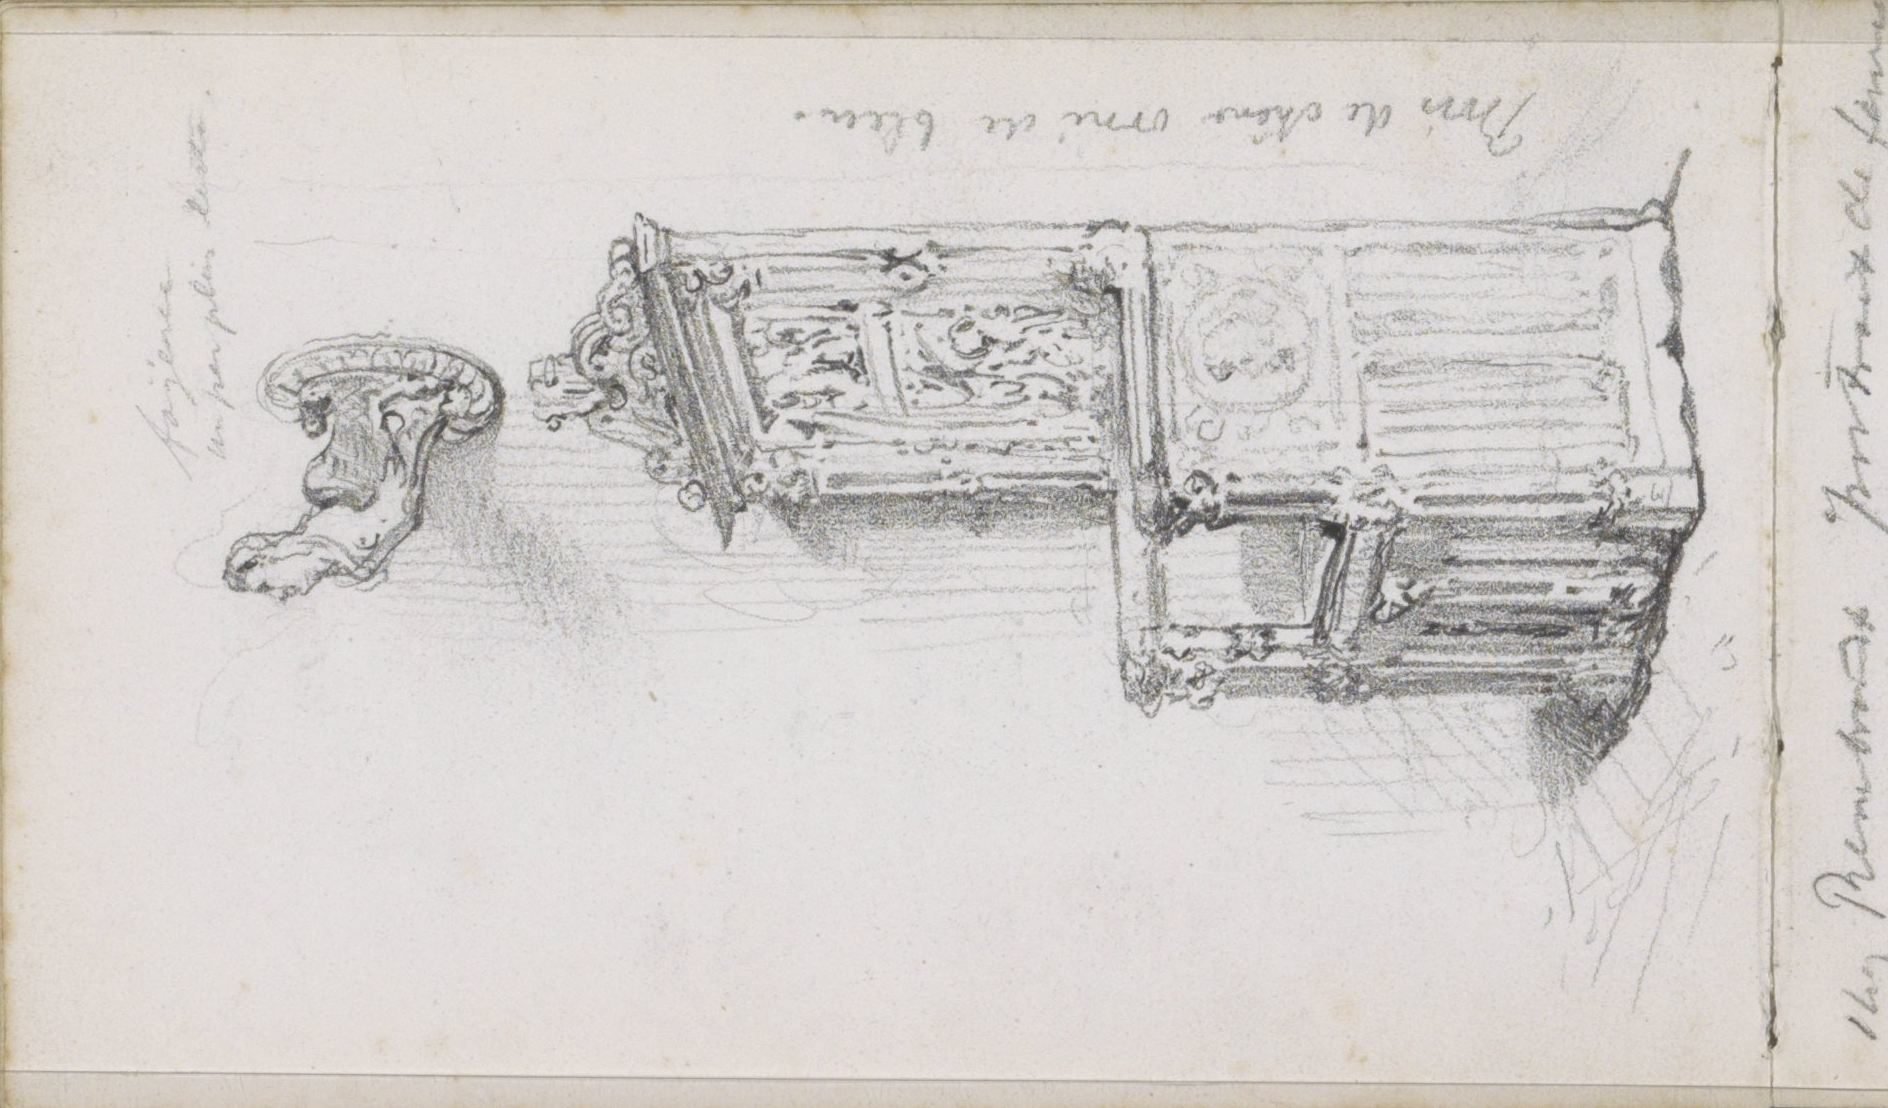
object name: sketchbook leaf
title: Gedecoreerde troon en een ornament, mogelijk een haak, in de vorm van een hoofd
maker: maria vos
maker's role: draughtsman, painter, print maker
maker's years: 1824-1906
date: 1811-1867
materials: paper, pencil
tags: ornament ~ human parts, throne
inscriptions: annotation: ‘[...]ence/ un pas plus [...]te/ Bois de chêne [...]né de bleu.’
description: Blad 4 verso uit een schetsboek met 40 bladen.